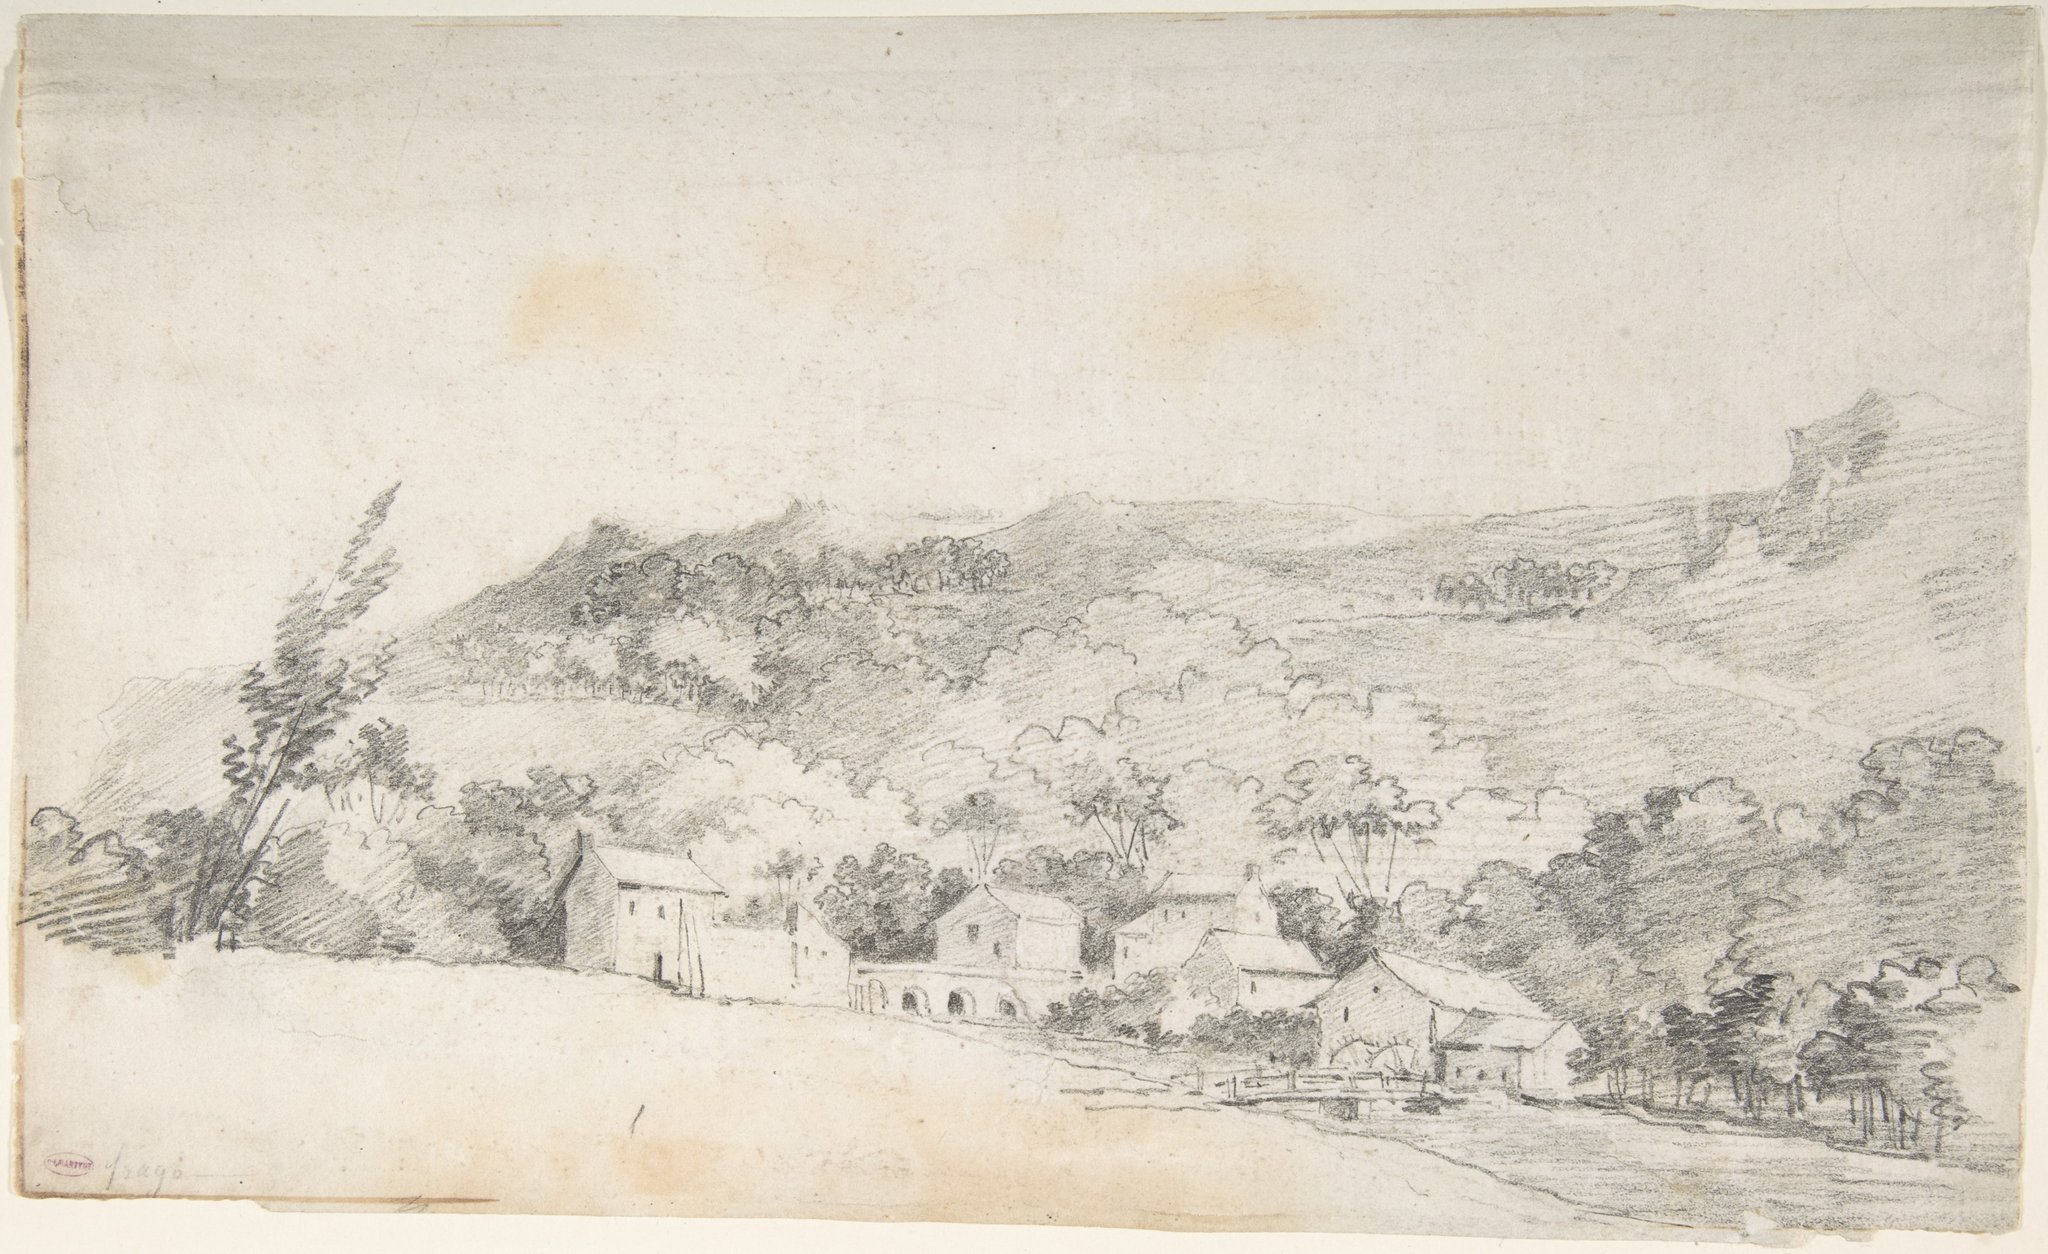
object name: drawing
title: Farm Buildings with Water Mill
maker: jean honoré fragonard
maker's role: artist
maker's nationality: french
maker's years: 1732-1806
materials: chalk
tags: houses,watermills,mountains,trees